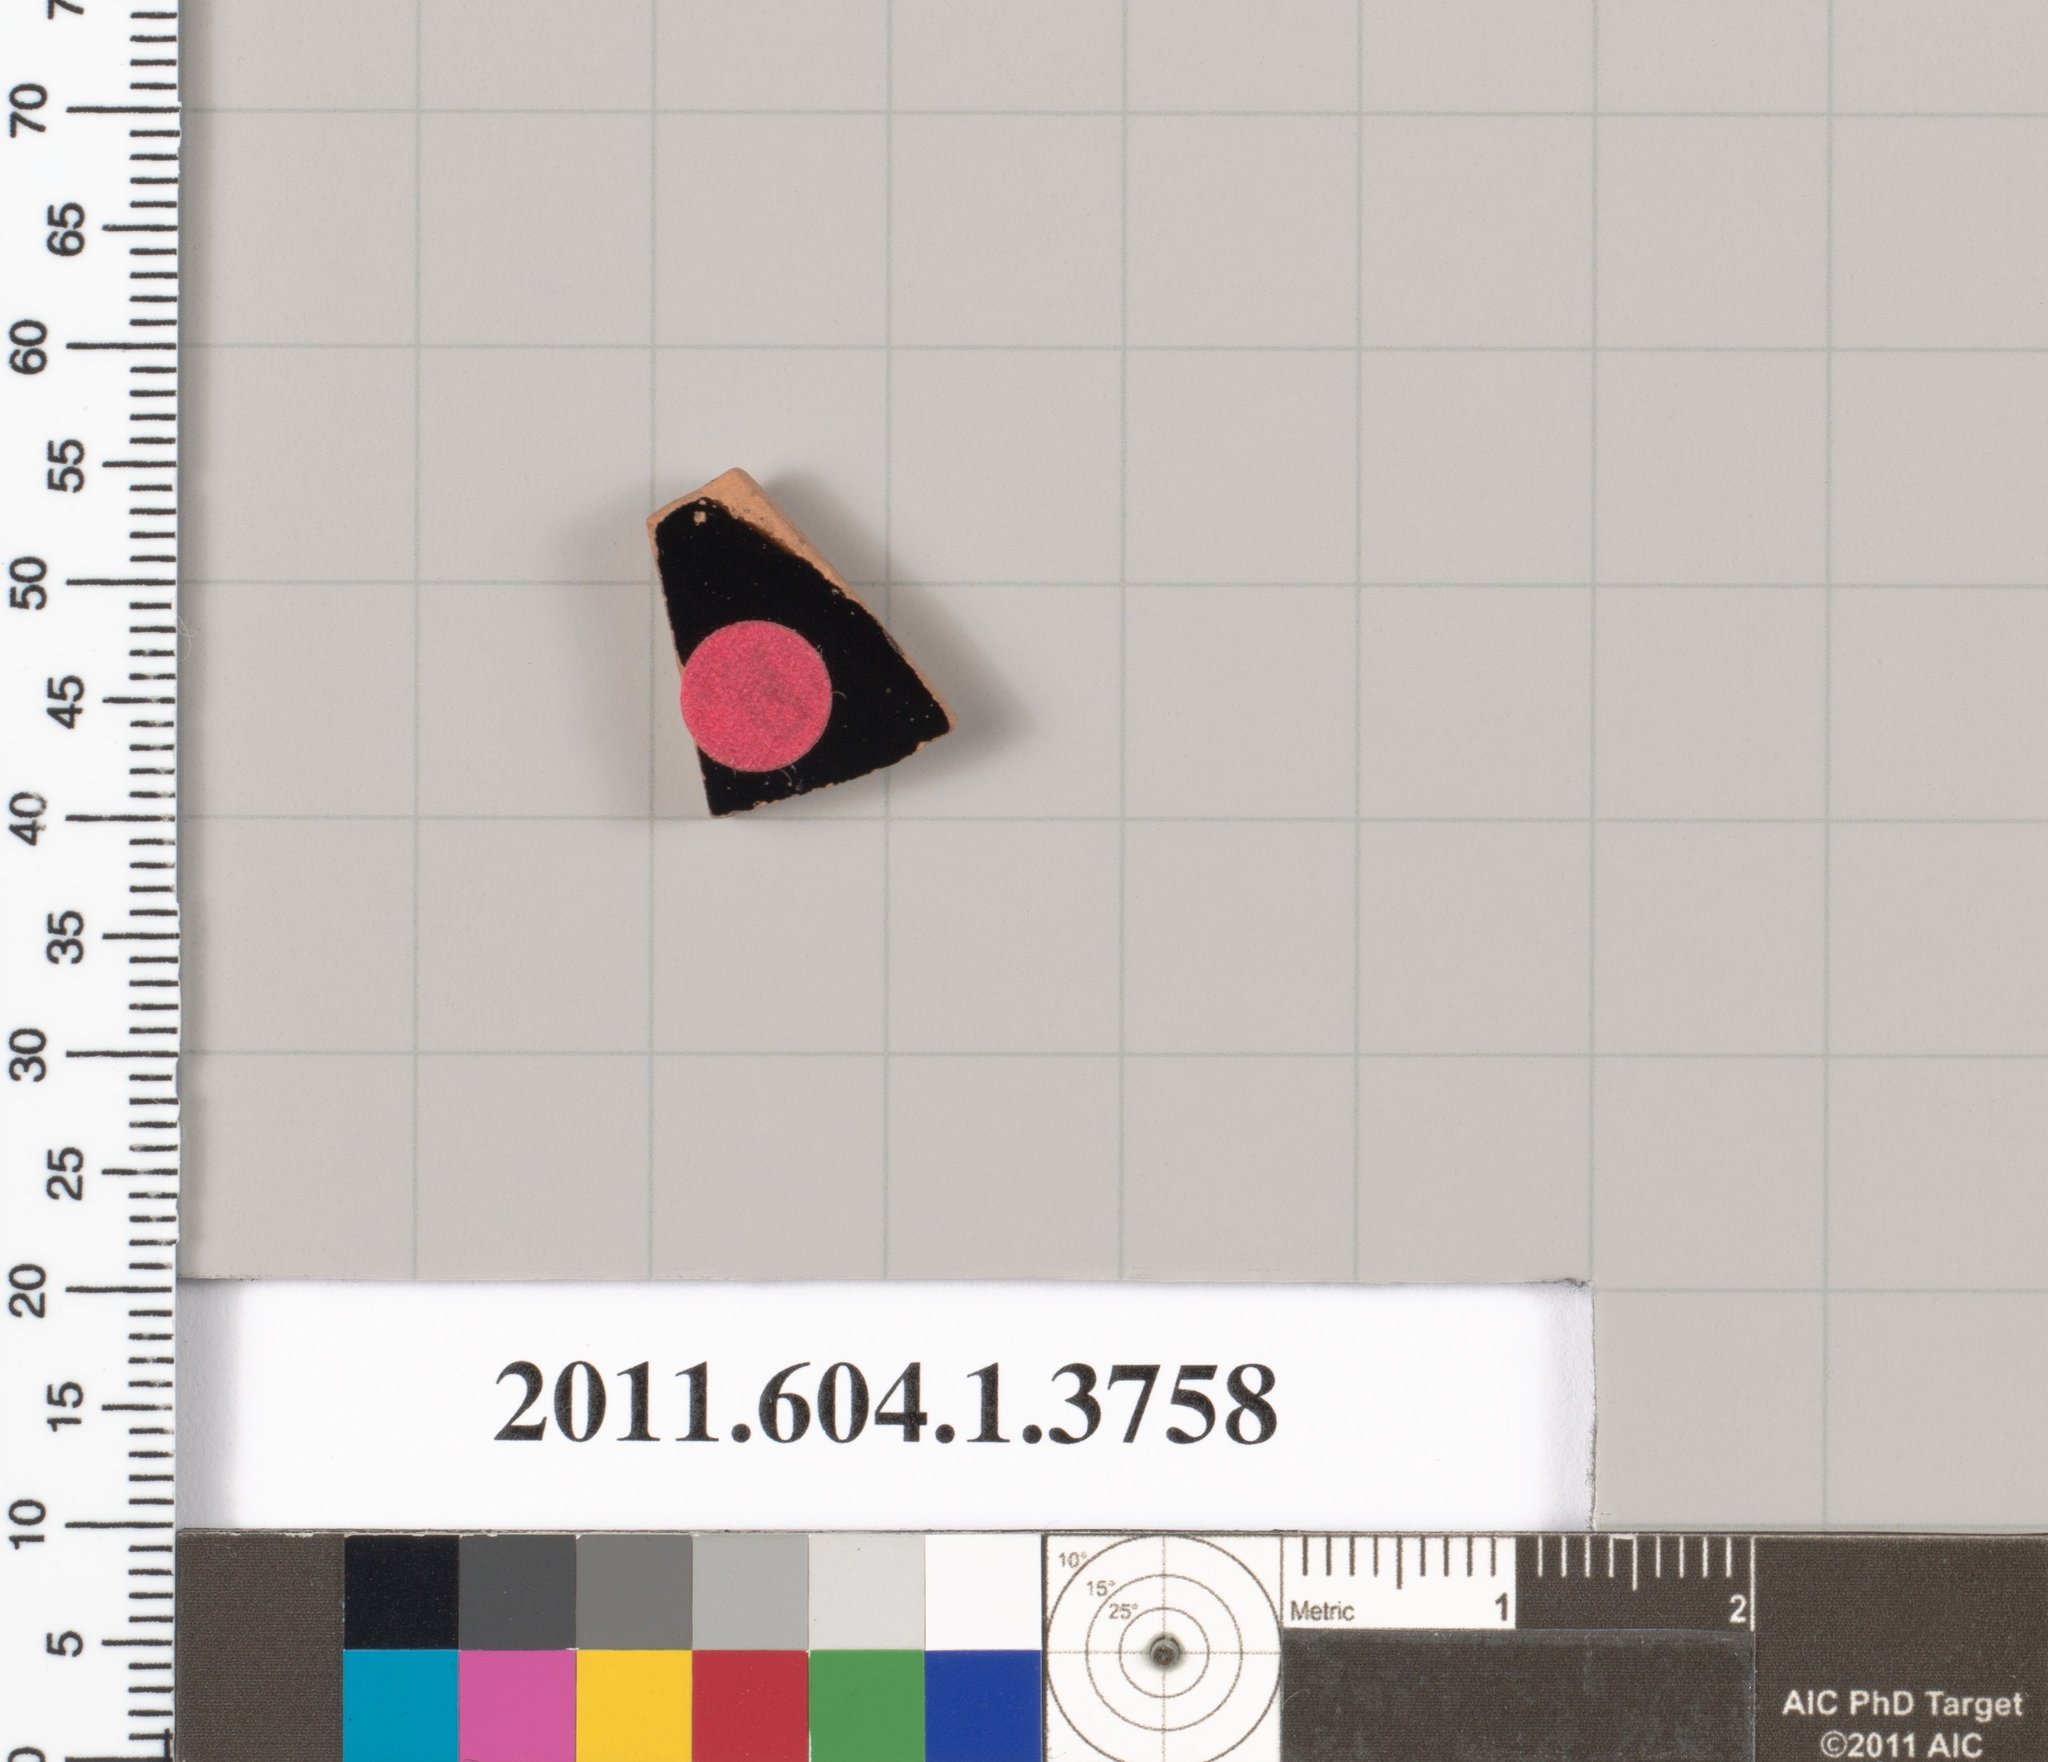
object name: kylix fragment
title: Terracotta fragment of a kylix (drinking cup)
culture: greek, attic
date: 475-451 BCE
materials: terracotta